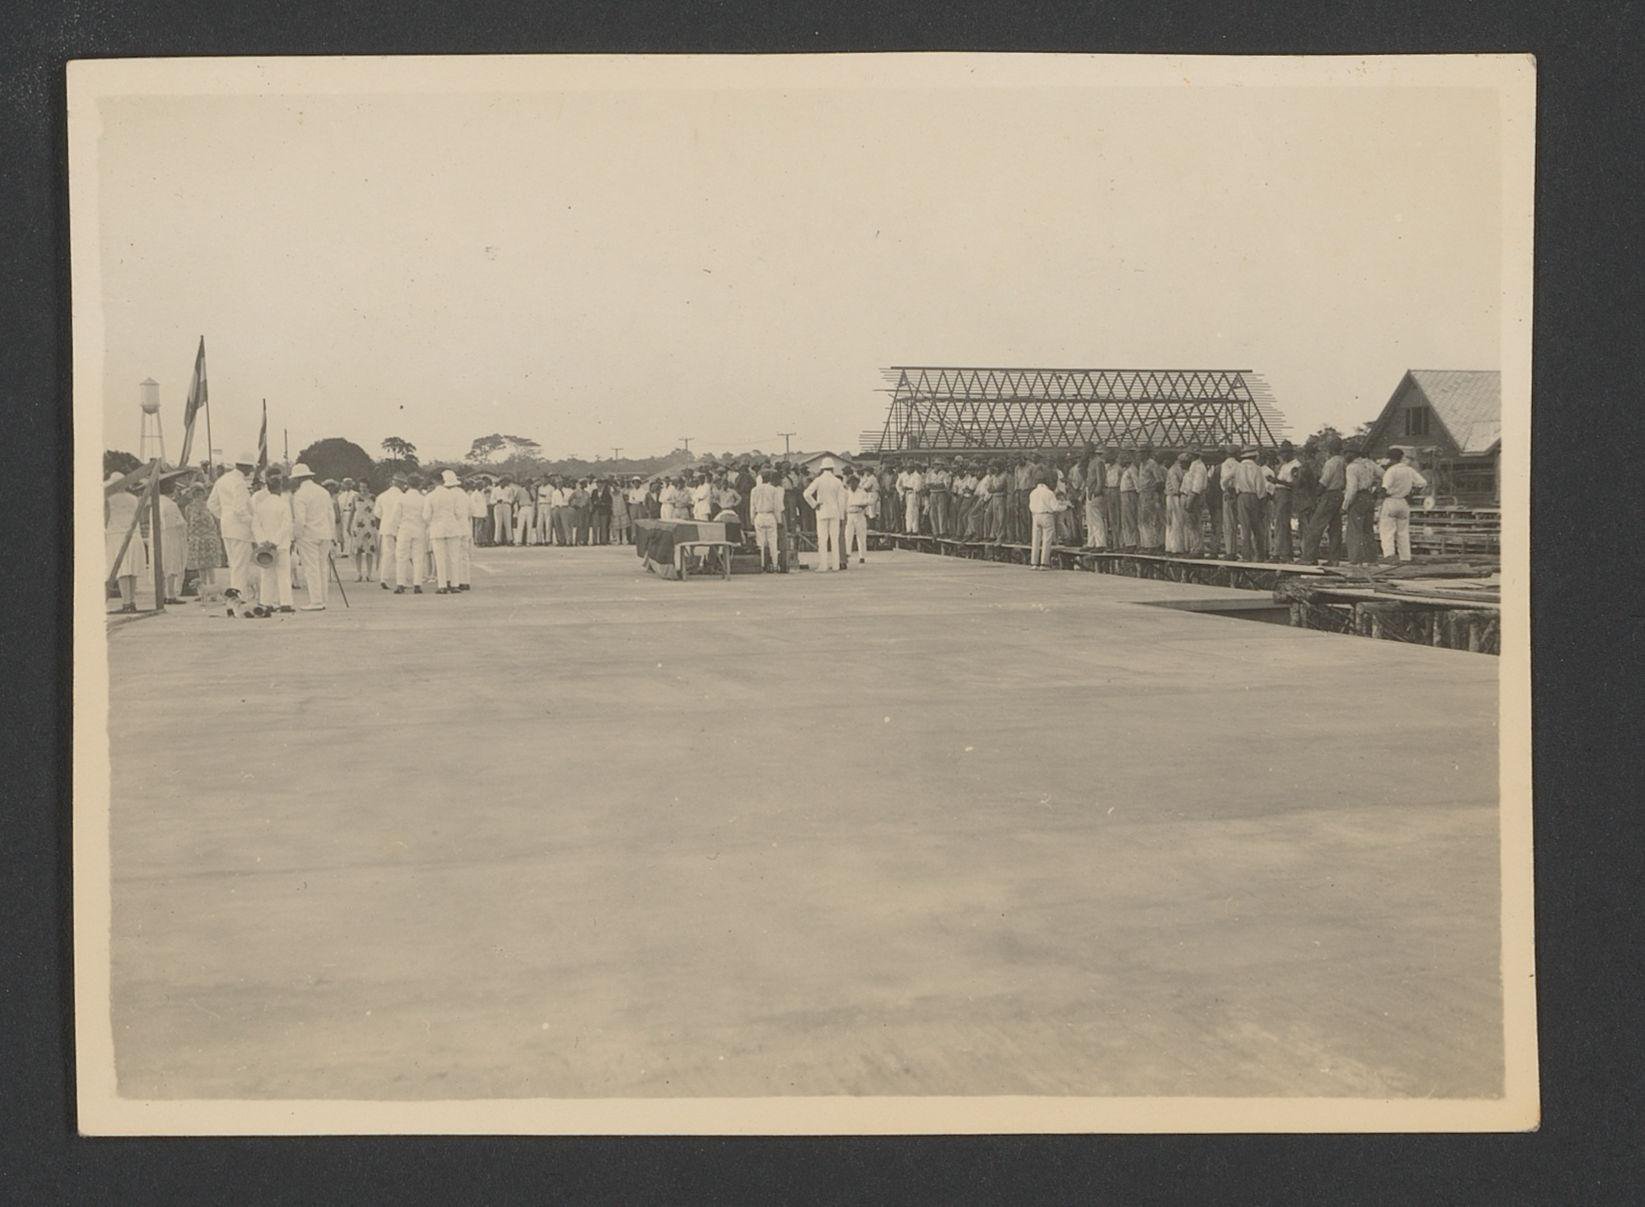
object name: album leaf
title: Mannen en ceremonie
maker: Anonymous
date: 1929-1930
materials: paper, photographic support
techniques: gelatin silver print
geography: suriname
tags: festivities, anonymous historical persons portrayed in a group, in a group-portrait, suriname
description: Albumblad met twee foto's: drie mannen poserend voor een muur en een menigte verzameld op een platform in de open lucht voor een ceremonie. Onderdeel van het album van de familie Guilonard over de bauxietwinning in Moengo en Albina in Suriname in de jaren 1929-1930.